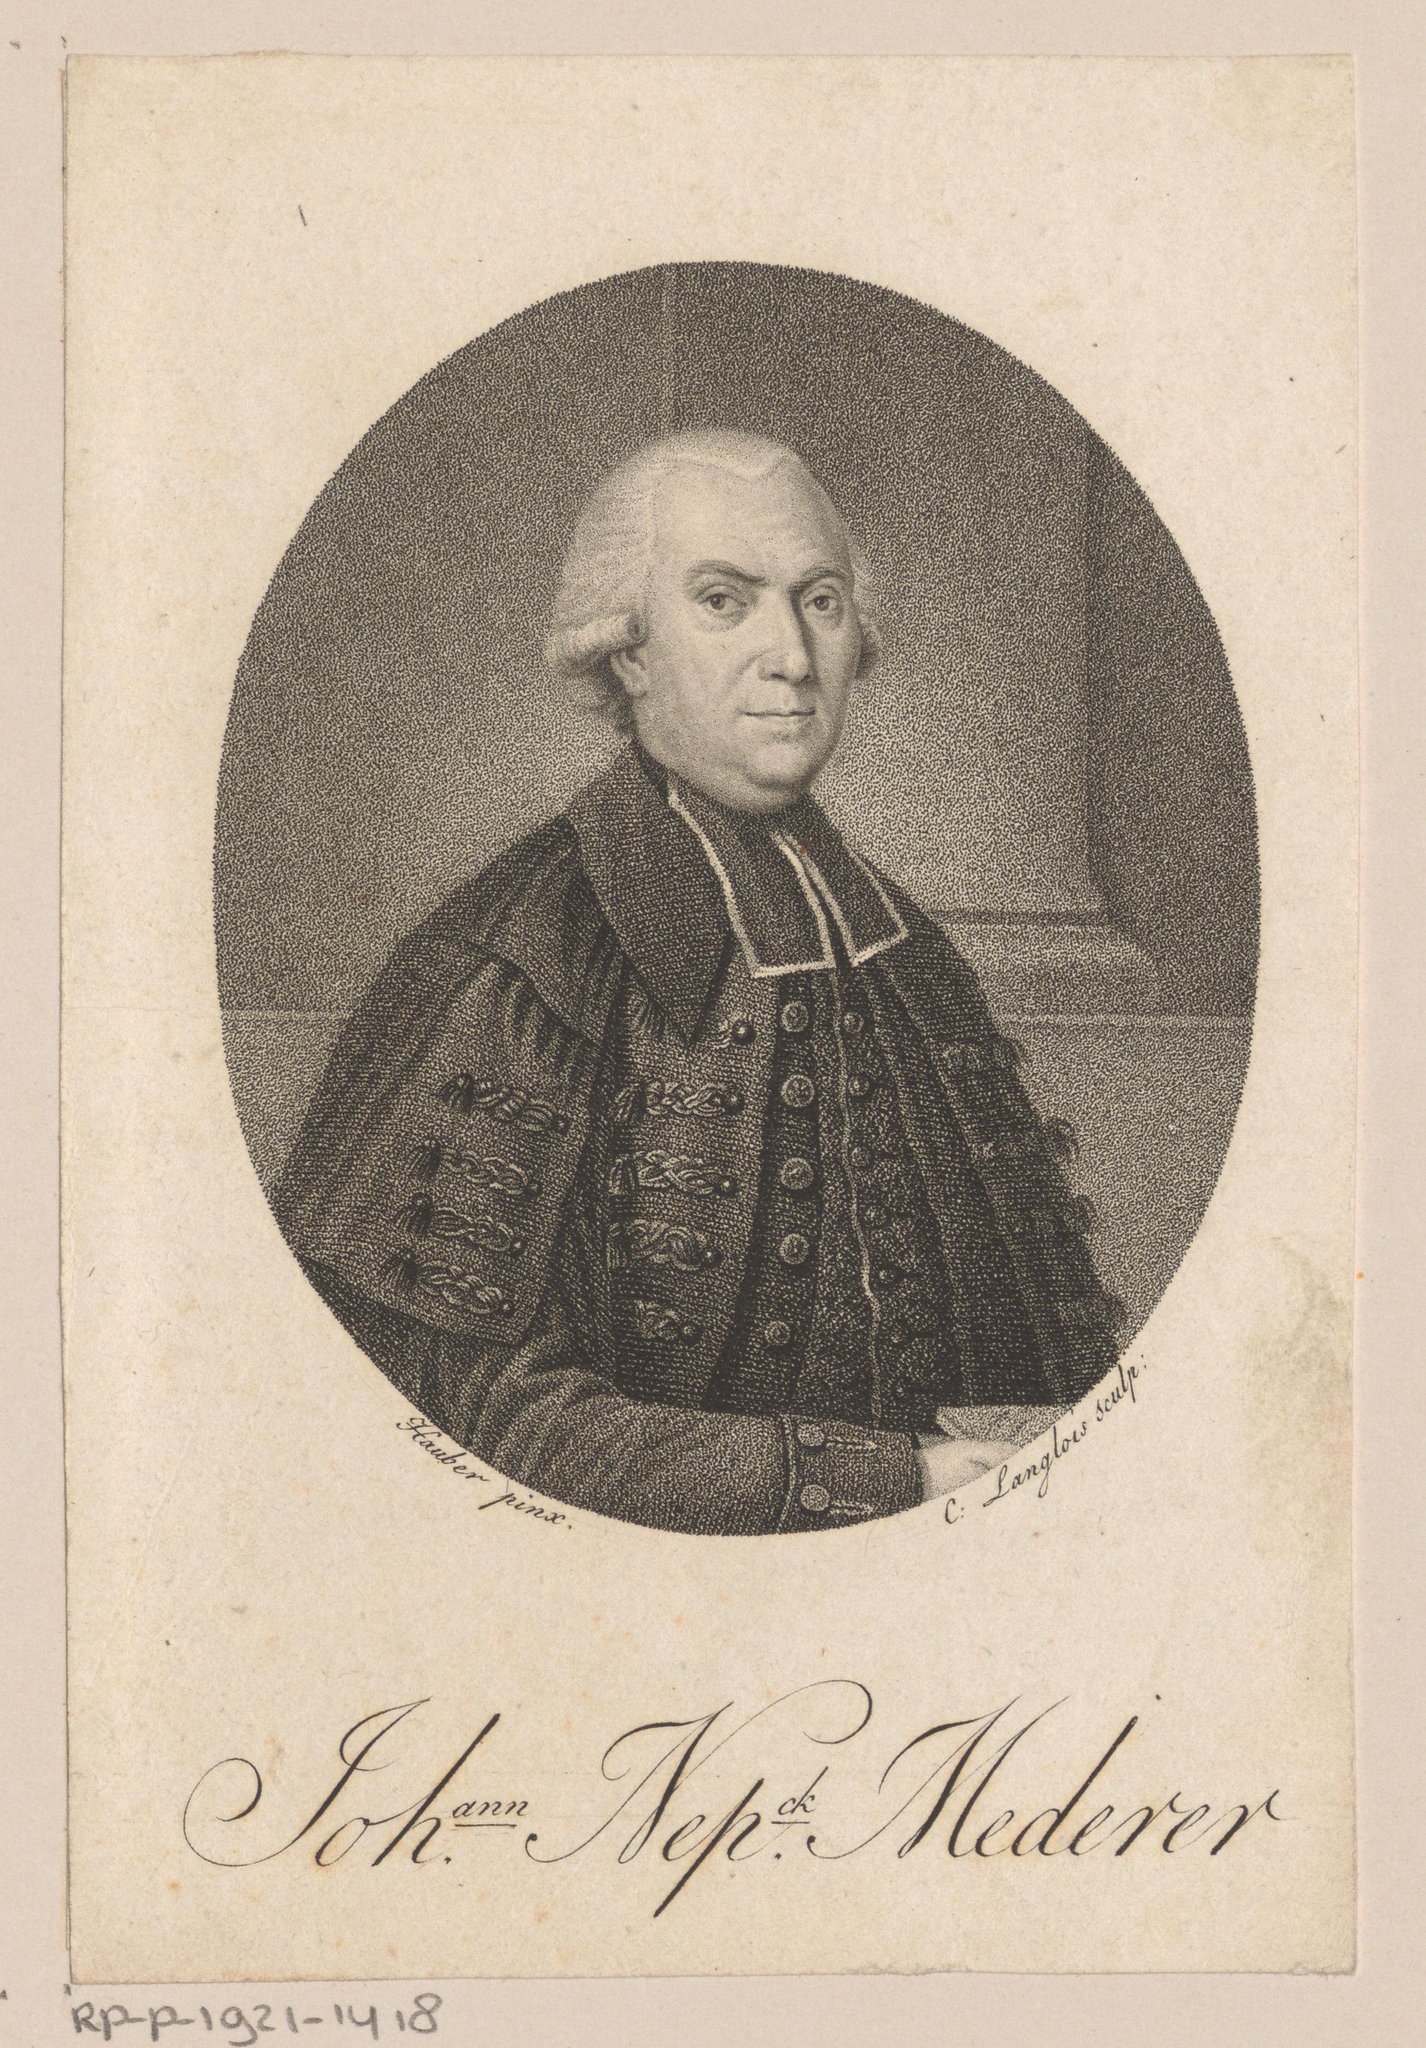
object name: print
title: Johann. Nepck. Nederer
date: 1806-1860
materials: paper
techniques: engraving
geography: munich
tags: historical persons, professor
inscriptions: collector's mark: Lugt 2233